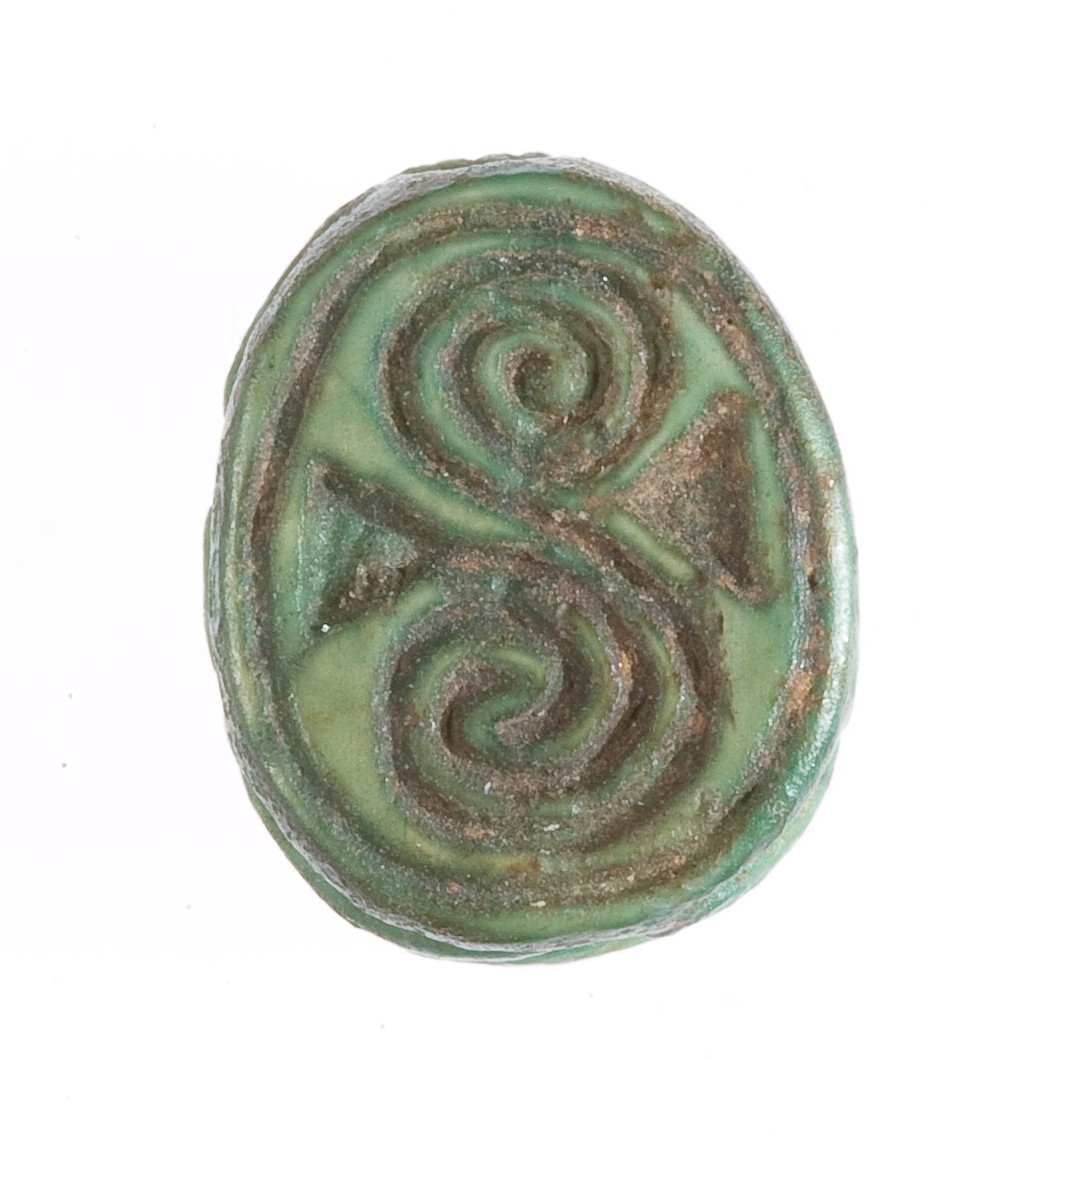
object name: scarab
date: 1550-1458 BCE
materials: stone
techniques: glazing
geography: egypt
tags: scarabs